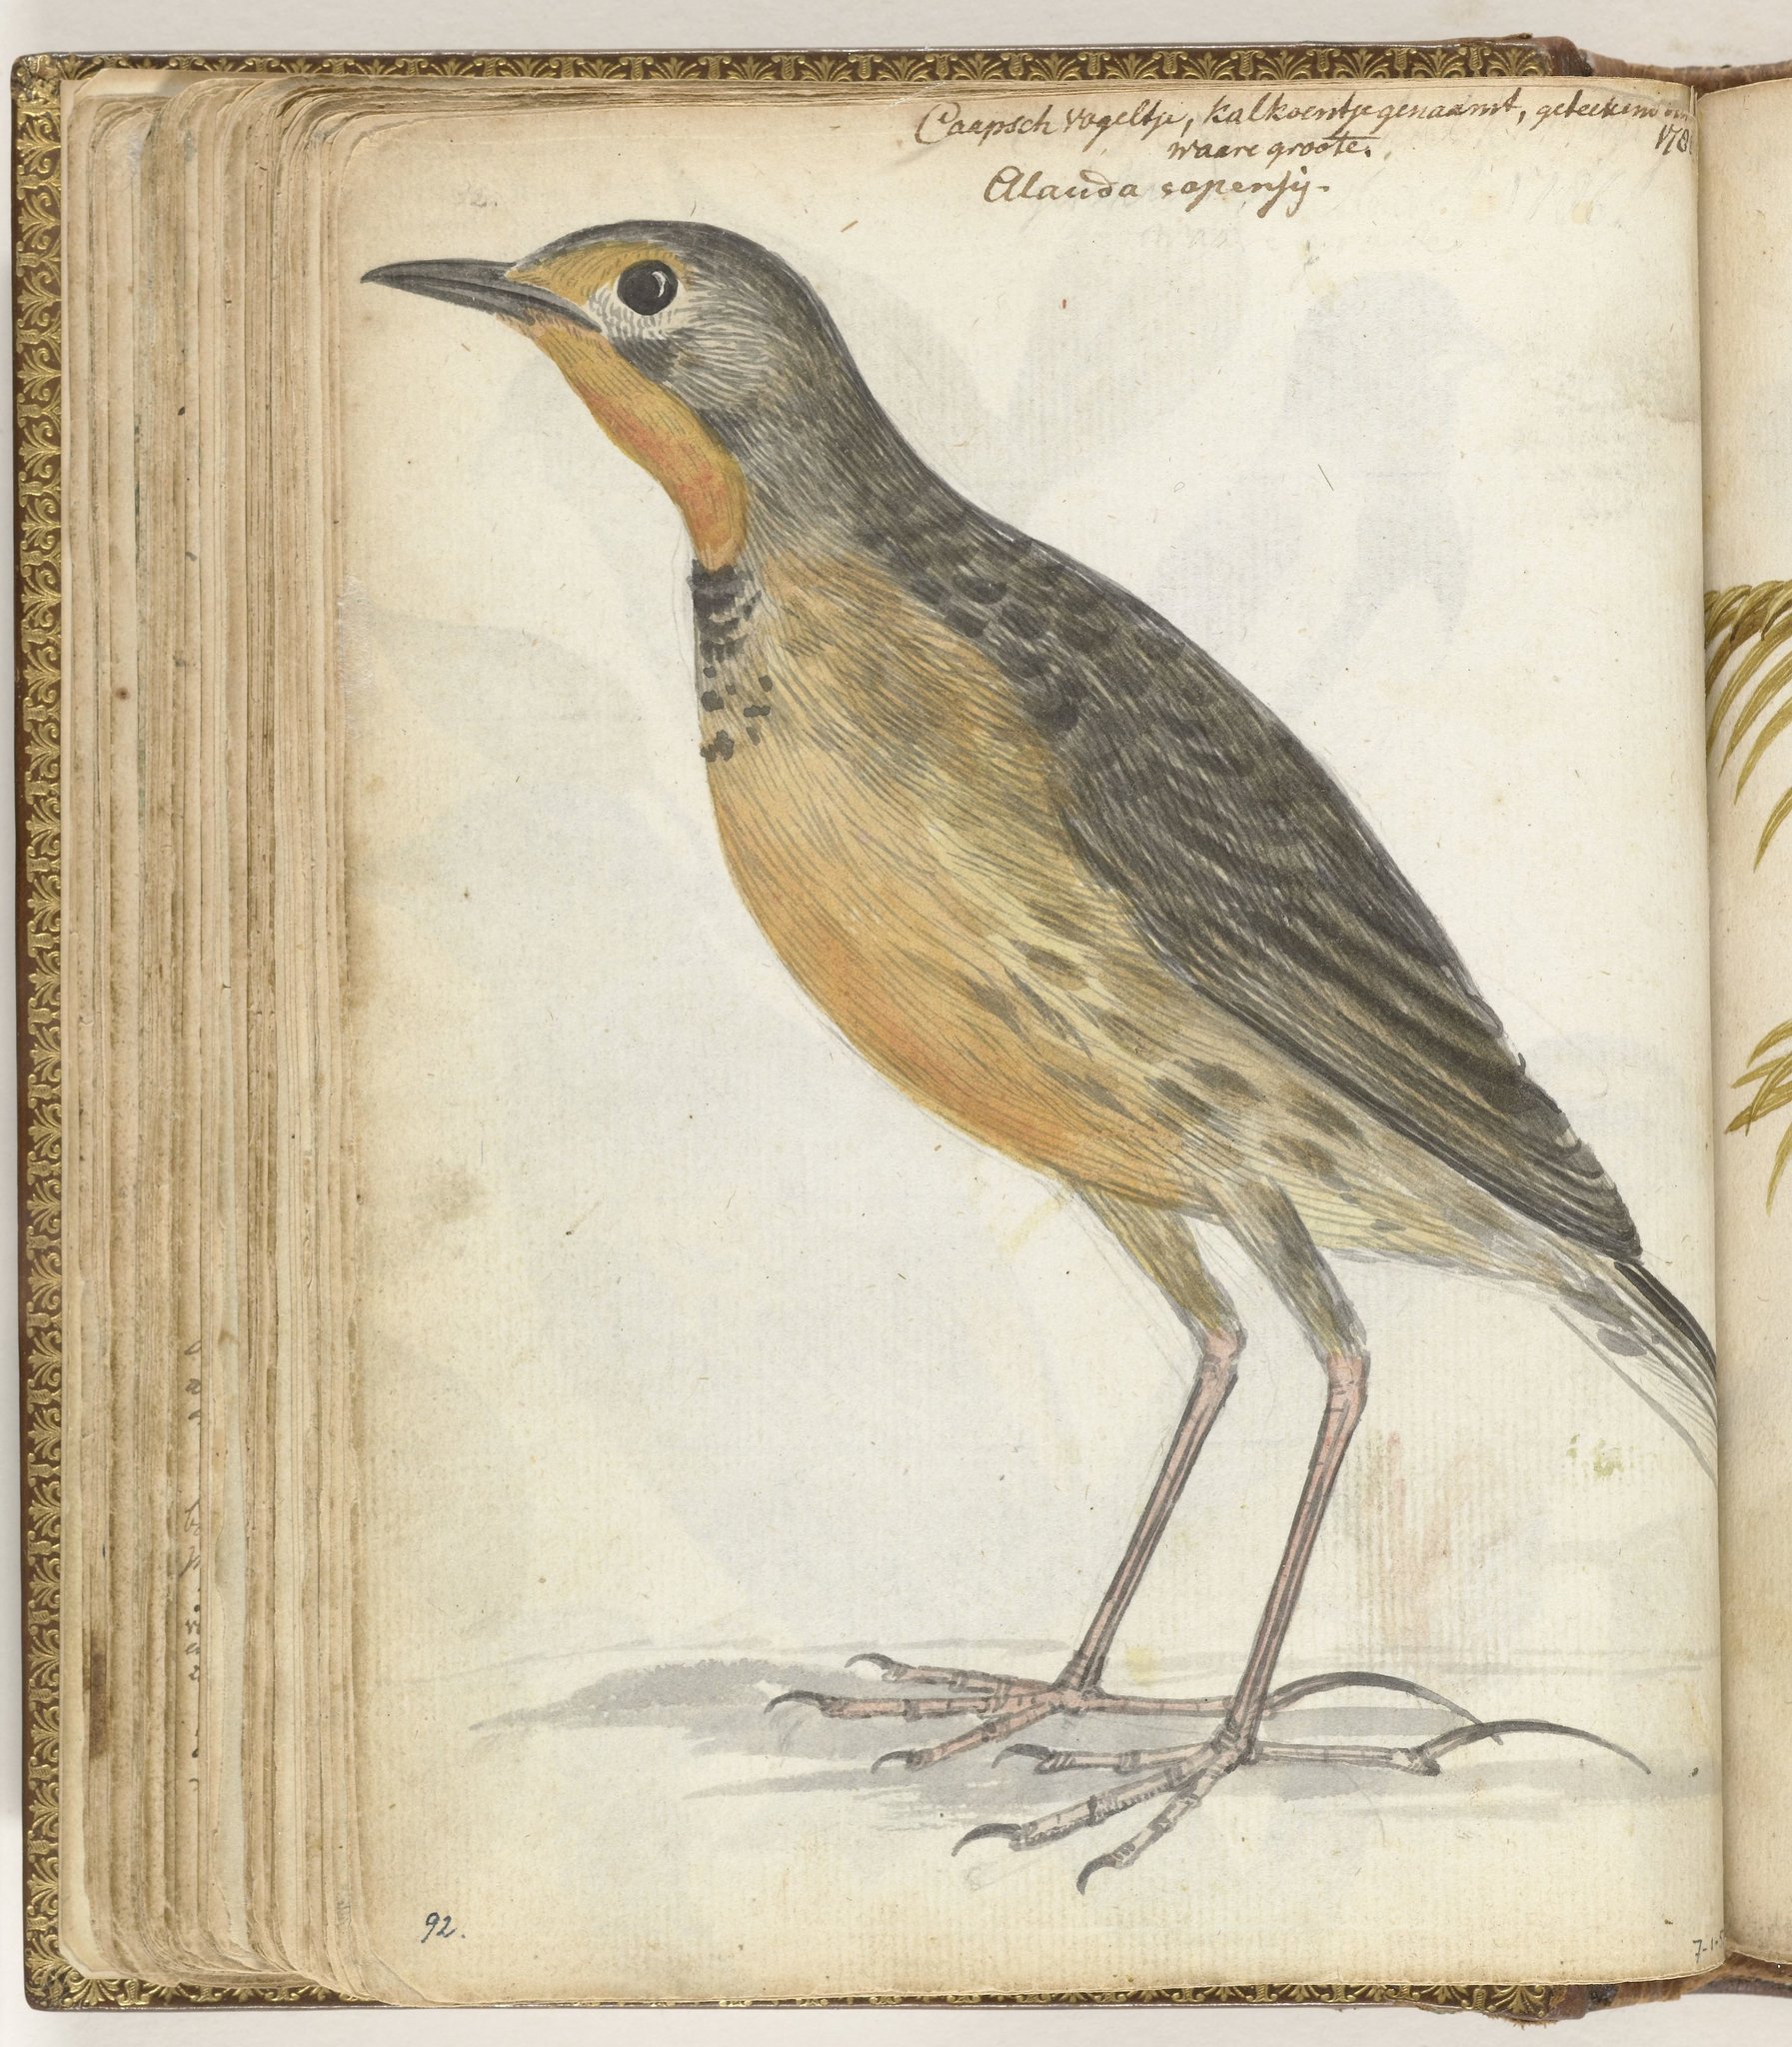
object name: drawing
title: Kaapse vogel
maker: jan brandes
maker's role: draughtsman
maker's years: 1743-1808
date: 1705-1786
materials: paper, pencil, watercolor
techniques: brush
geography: cape town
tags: birds, cape of good hope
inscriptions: inscription: ‘Caapsch Vogeltje, kalkoentje genaamt, geteekend den ... 1786 / waare groote / Alauda capensis’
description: Kleurtekening van een vogel die voorkomt op Kaap de Goede Hoop: 'Caapsch vogeltje, genaamt kalkoentje'. Op ware grootte. Met opschrift. Onderdeel uit het schetsboek van Jan Brandes, dl. 1 (1808), p. 92.